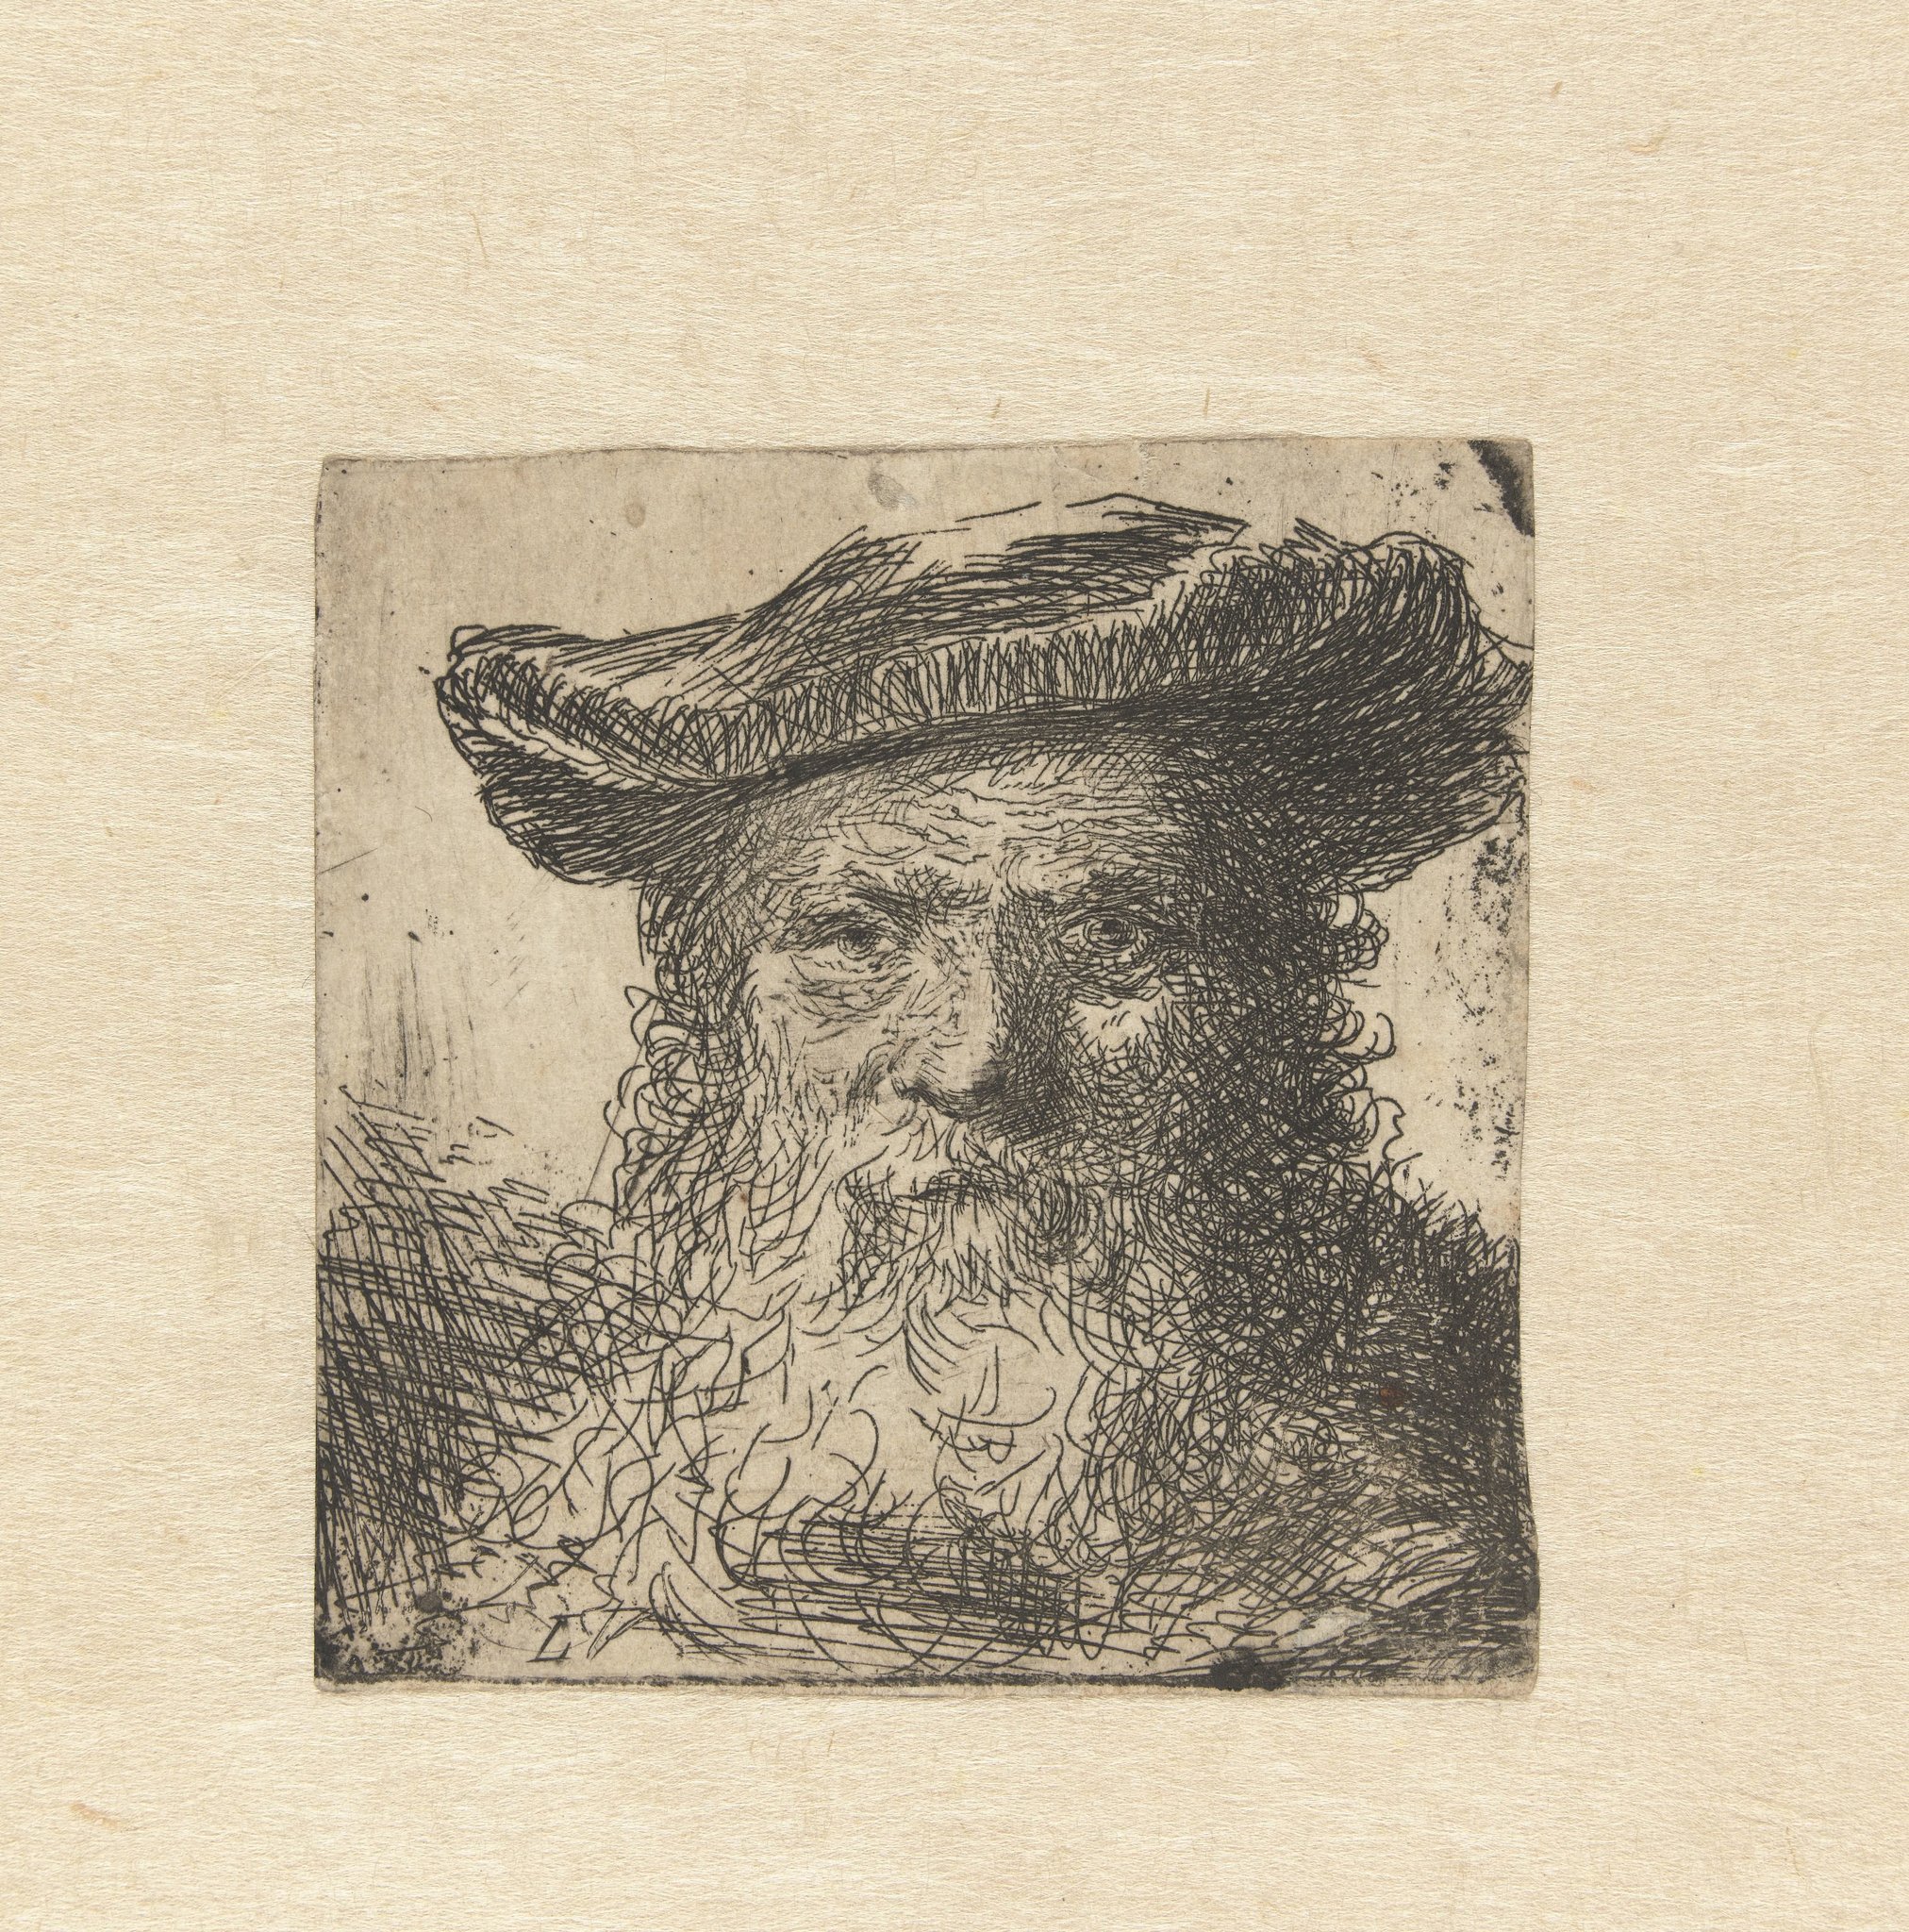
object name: print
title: Kop van een oude man met baard en hoed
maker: Anonymous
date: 1645-1655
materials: paper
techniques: etching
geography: netherlands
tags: old man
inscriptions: collector's mark: Lugt 2228a